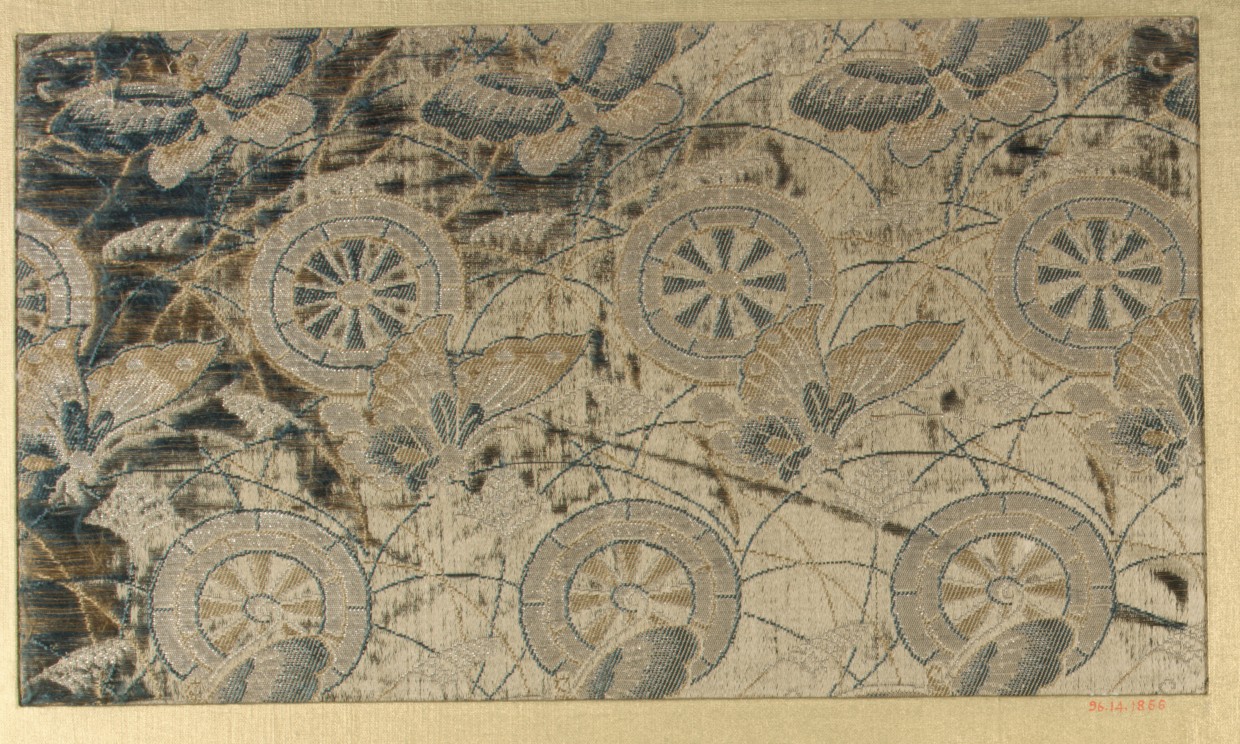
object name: piece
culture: japanese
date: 1701-1900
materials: silk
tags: butterflies